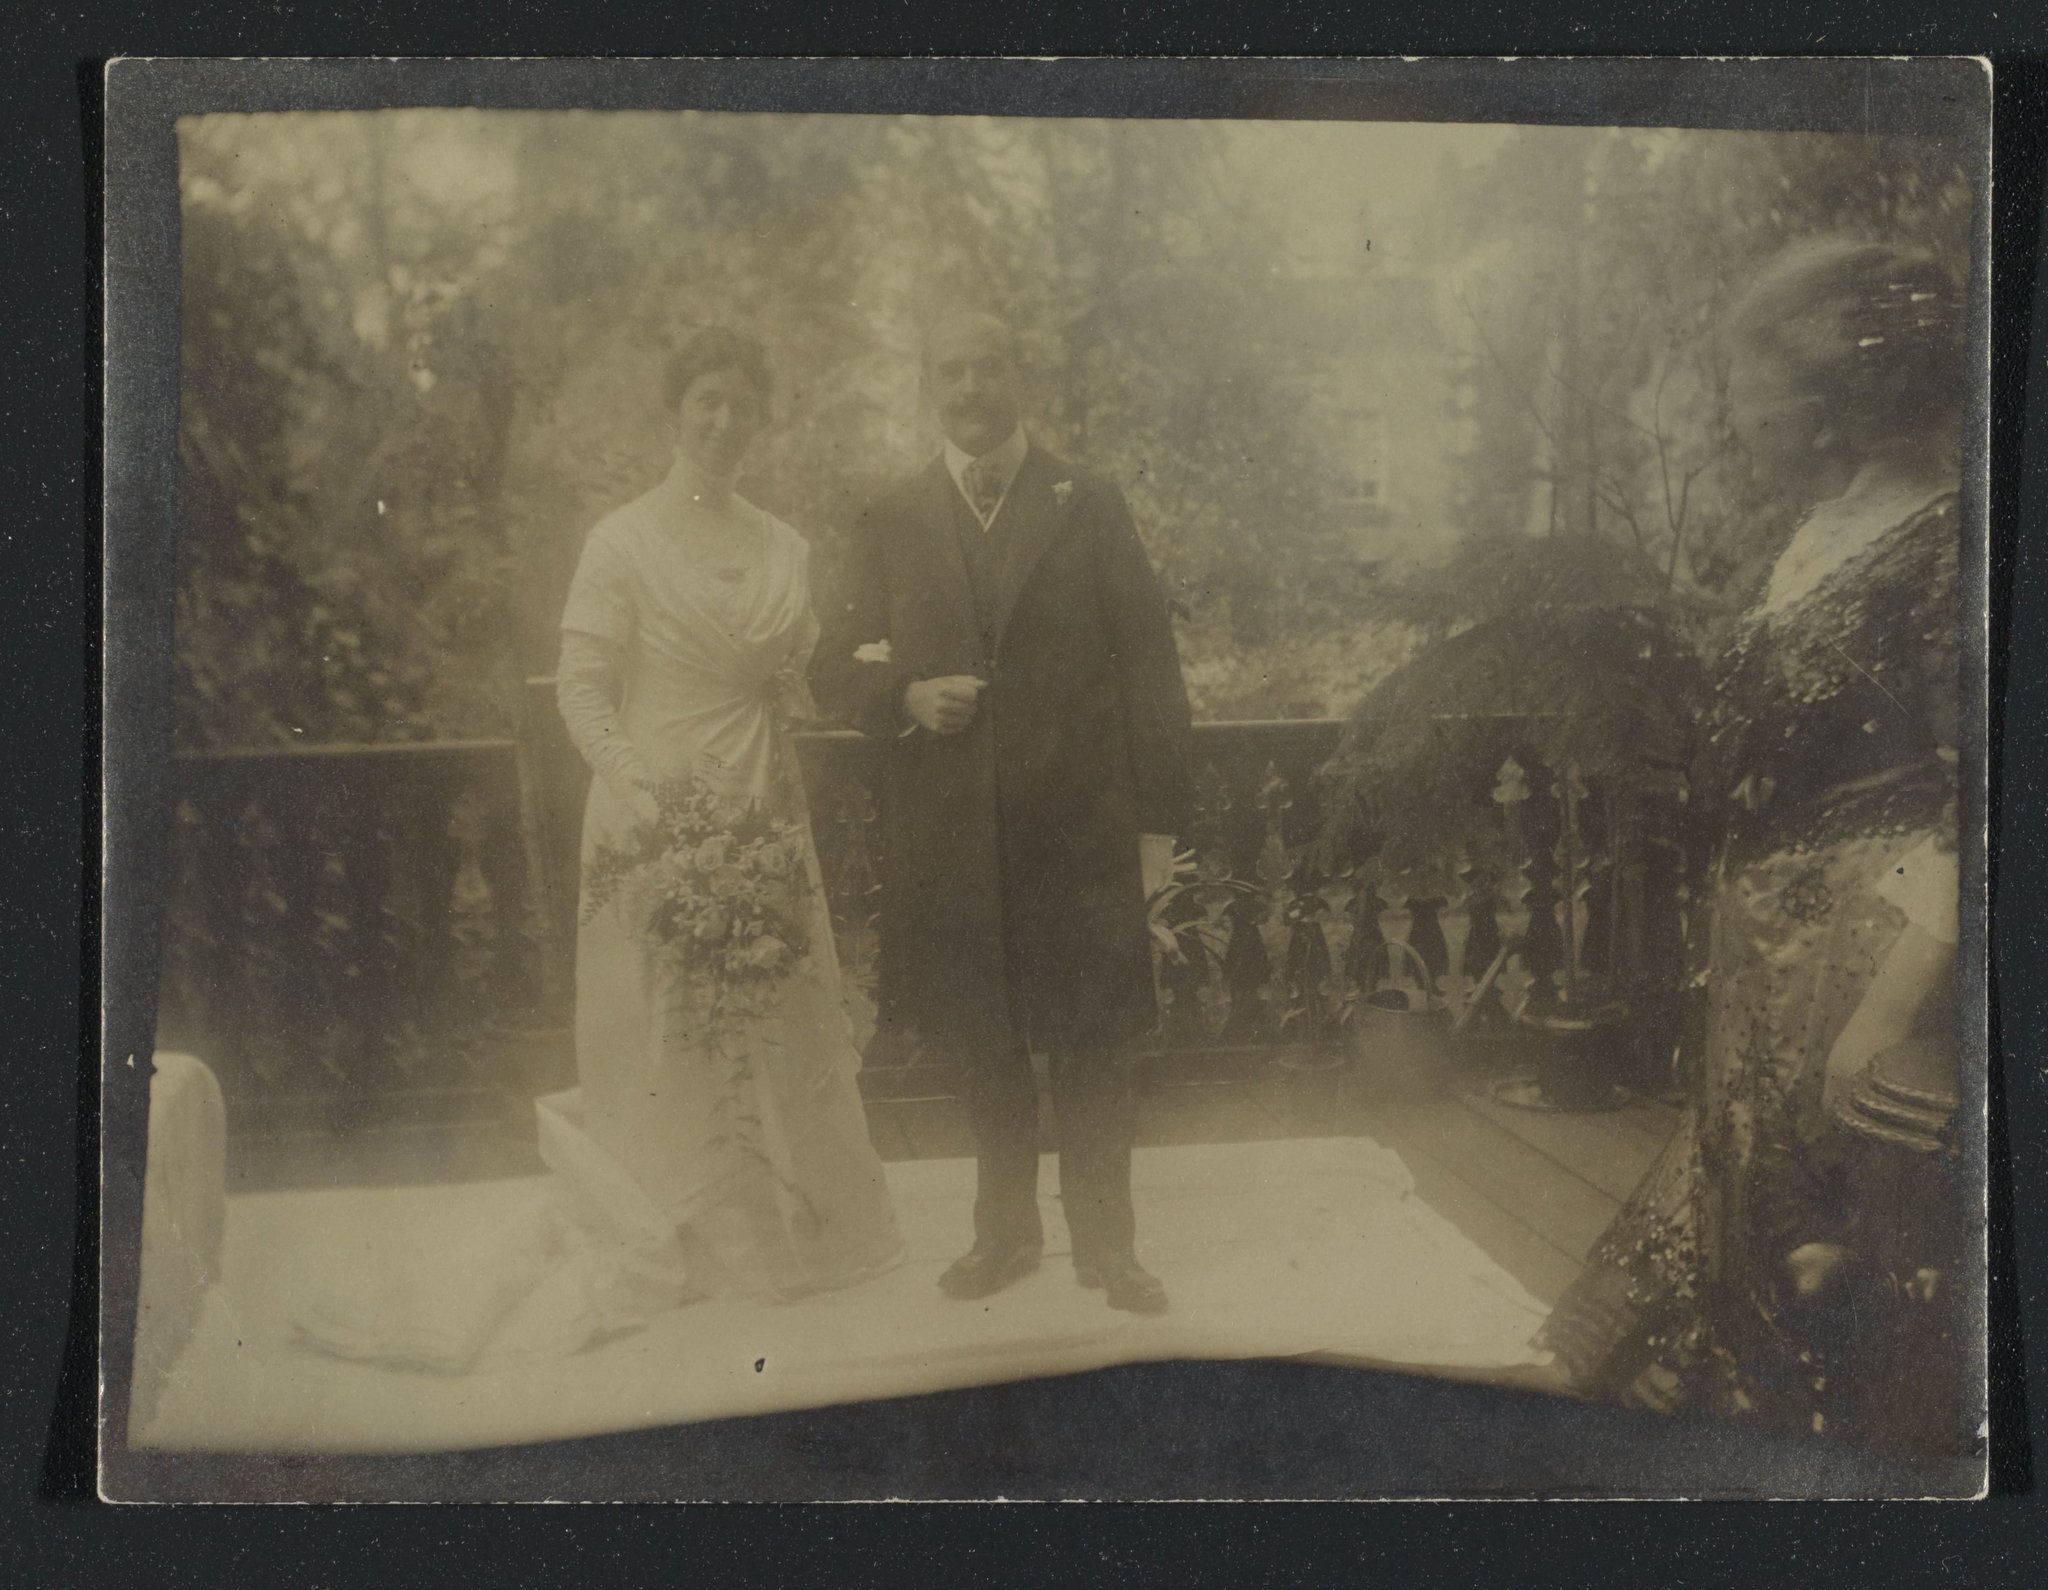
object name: photograph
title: Bruidspaar Robert-De Roever op het balkon van Vondelstraat 118 te Amsterdam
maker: Anonymous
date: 1909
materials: photographic support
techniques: gelatin silver print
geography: amsterdam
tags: wibbina maria barones korteweg-d'aulnis de bourrouil, amsterdam, marriage, married couple, 'matrimonium'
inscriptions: inscription: ‘trouwfoto 1909 / trouwjapon geschenk aan het Rijksmuseum 1967 met de schoentjes van glacé / + 1971 A.M.L.E. de Roever dochter van mr. N. de Roever, archivaris in Amsterdam met ....?...., Zwitser van geboorte / vanuit het huis van mevrouw (en prof.) Korteweg-d'Aulnis de Bourrouil (mevrouw komt op de voorgr. r. voor) Vondelstraat 118 te Amsterdam (is mijn oud-tante vernoemd naar mijn grootmoeder A.M.L.E. van Assendelft-de Coningh-de Roever).’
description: Foto van bruidspaar Robert-De Roever staand op een wit laken op het balkon van Vondelstraat 118, huis van professor en mevrouw Korteweg-d'Aulnis de Bourrouil. Achter het bruidspaar is de tuin en het huis aan de achterkant zichtbaar. De bruid heeft haar linkerhand op de arm van de bruidegom gelegd, in de andere hand houdt zij het bruidsboeket. Middenvoor in het décolleté is (vermoedelijk) een broche zichtbaar. Zij draagt het haar plat om het hoofd met een scheiding in het midden. De bruidegom gaat gekleed in een geklede jas, vest, wit overhemd met stijf boord en geknoopte das. Op zijn linkerrevers een kleine corsage. Beide handen zijn ongeschoeid; de bruid draagt daarentegen handschoenen. In de rechterhoek is op de voorgrond een vrouw te zien, die naar het bruidspaar kijkt. Zij is mevrouw Korteweg-d'Aulnis de Bourrouil, pleegmoeder van Anna Maria Louise Elisabeth de Roever (dochter van de stadarchivaris van Amsterdam Nicolaas de Roever).